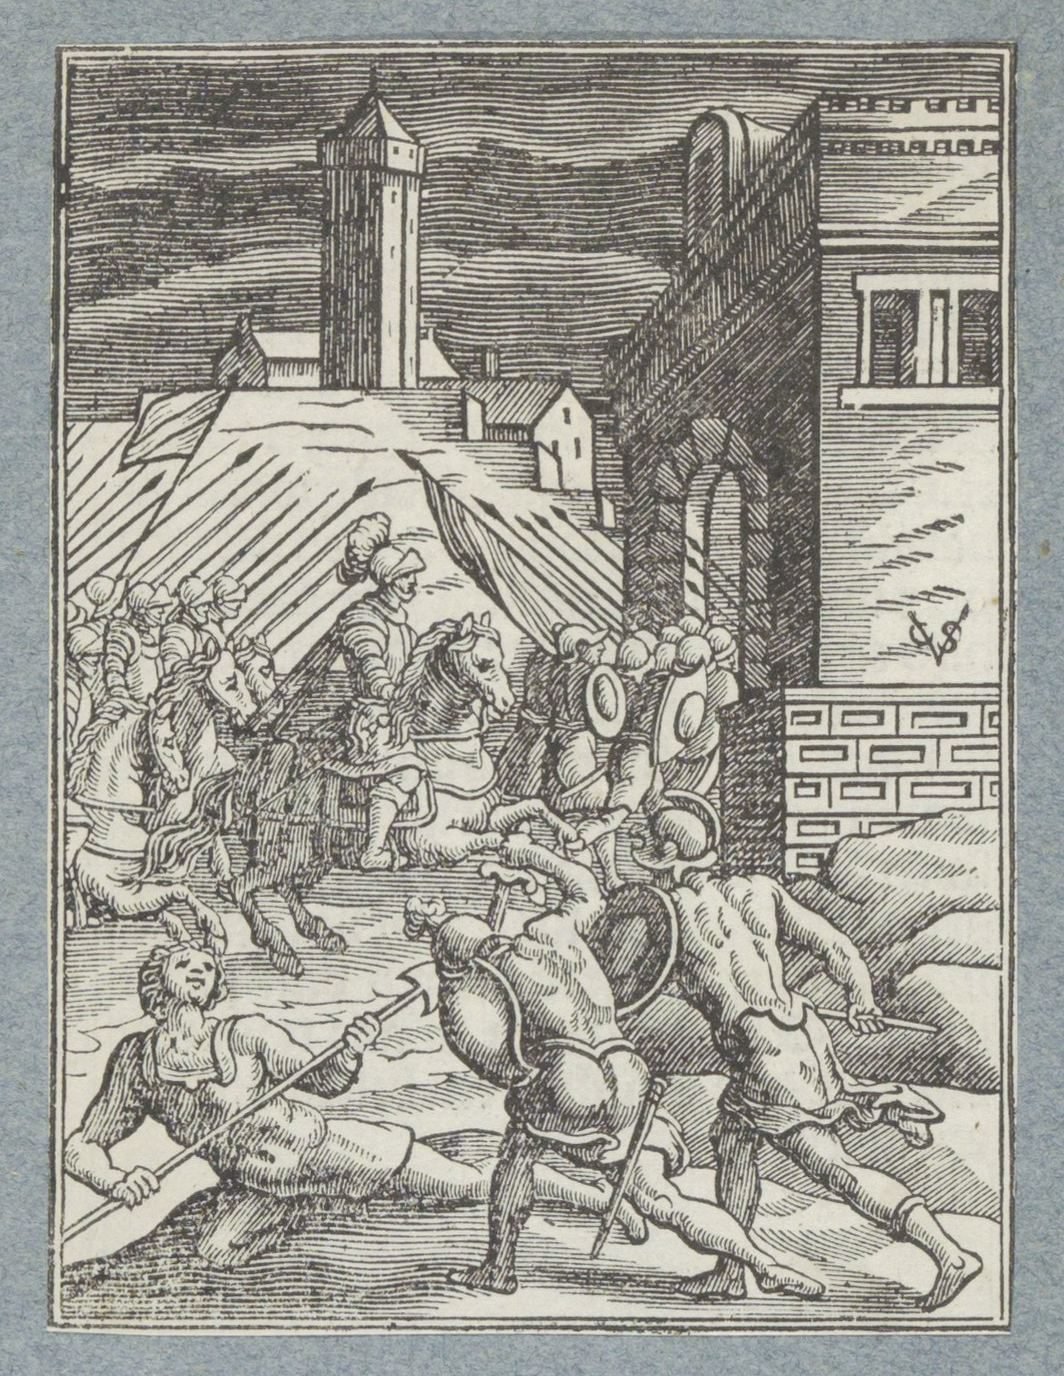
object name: print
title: Leger trekt een stad binnen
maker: pieter jacobsz. paets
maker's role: publisher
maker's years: 1587-1667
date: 1645-1646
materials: paper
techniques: woodcut, pasting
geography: amsterdam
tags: breaking into city or fortress ~ siege, (military) attack, siege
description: De prent werd gemaakt voor de uitgaven van P.J. Paets uit Amsterdam. Ze komt in ieder geval voor in: Bibels Tresoor ofte der zielen lusthof. Amsterdam, P.J. Paets, 1646. Mogelijk ook in: Historien ende Prophetien. [Amsterdam], P.J. Paets, 1645.